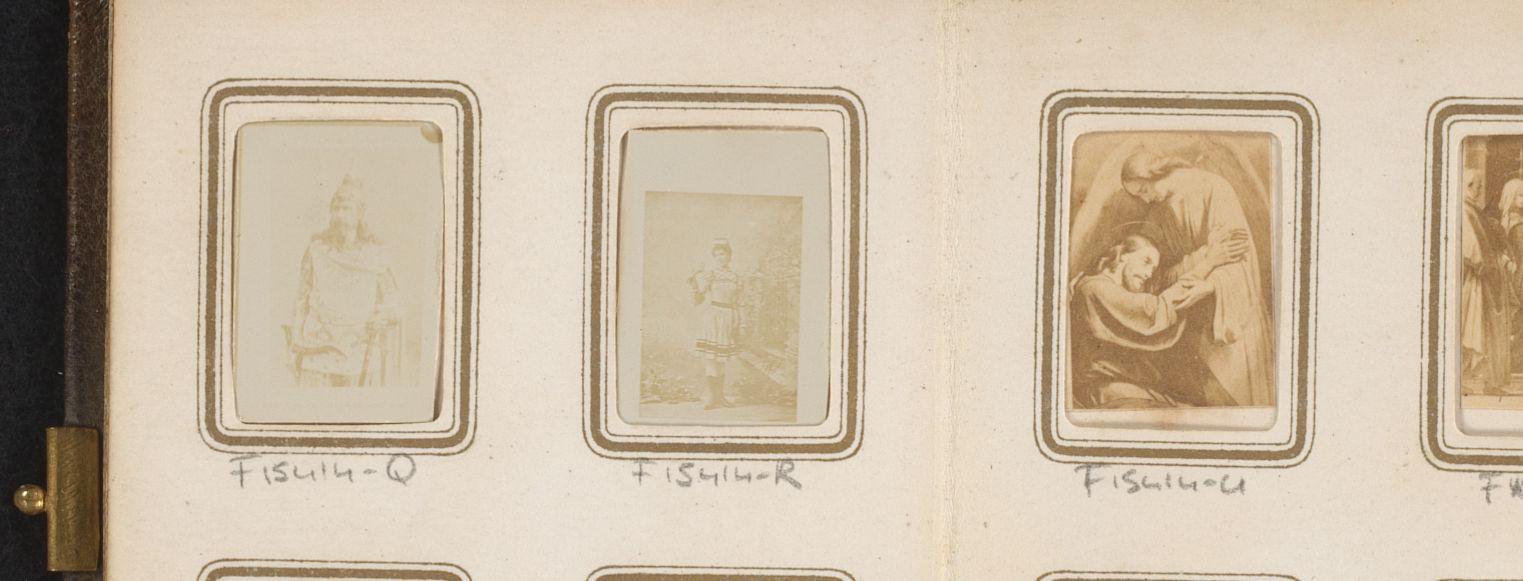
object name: photograph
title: Miniatuurportret van een vrouw in historisch kostuum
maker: Anonymous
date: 1880-1910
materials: paper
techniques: collodion silver print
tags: historical costume